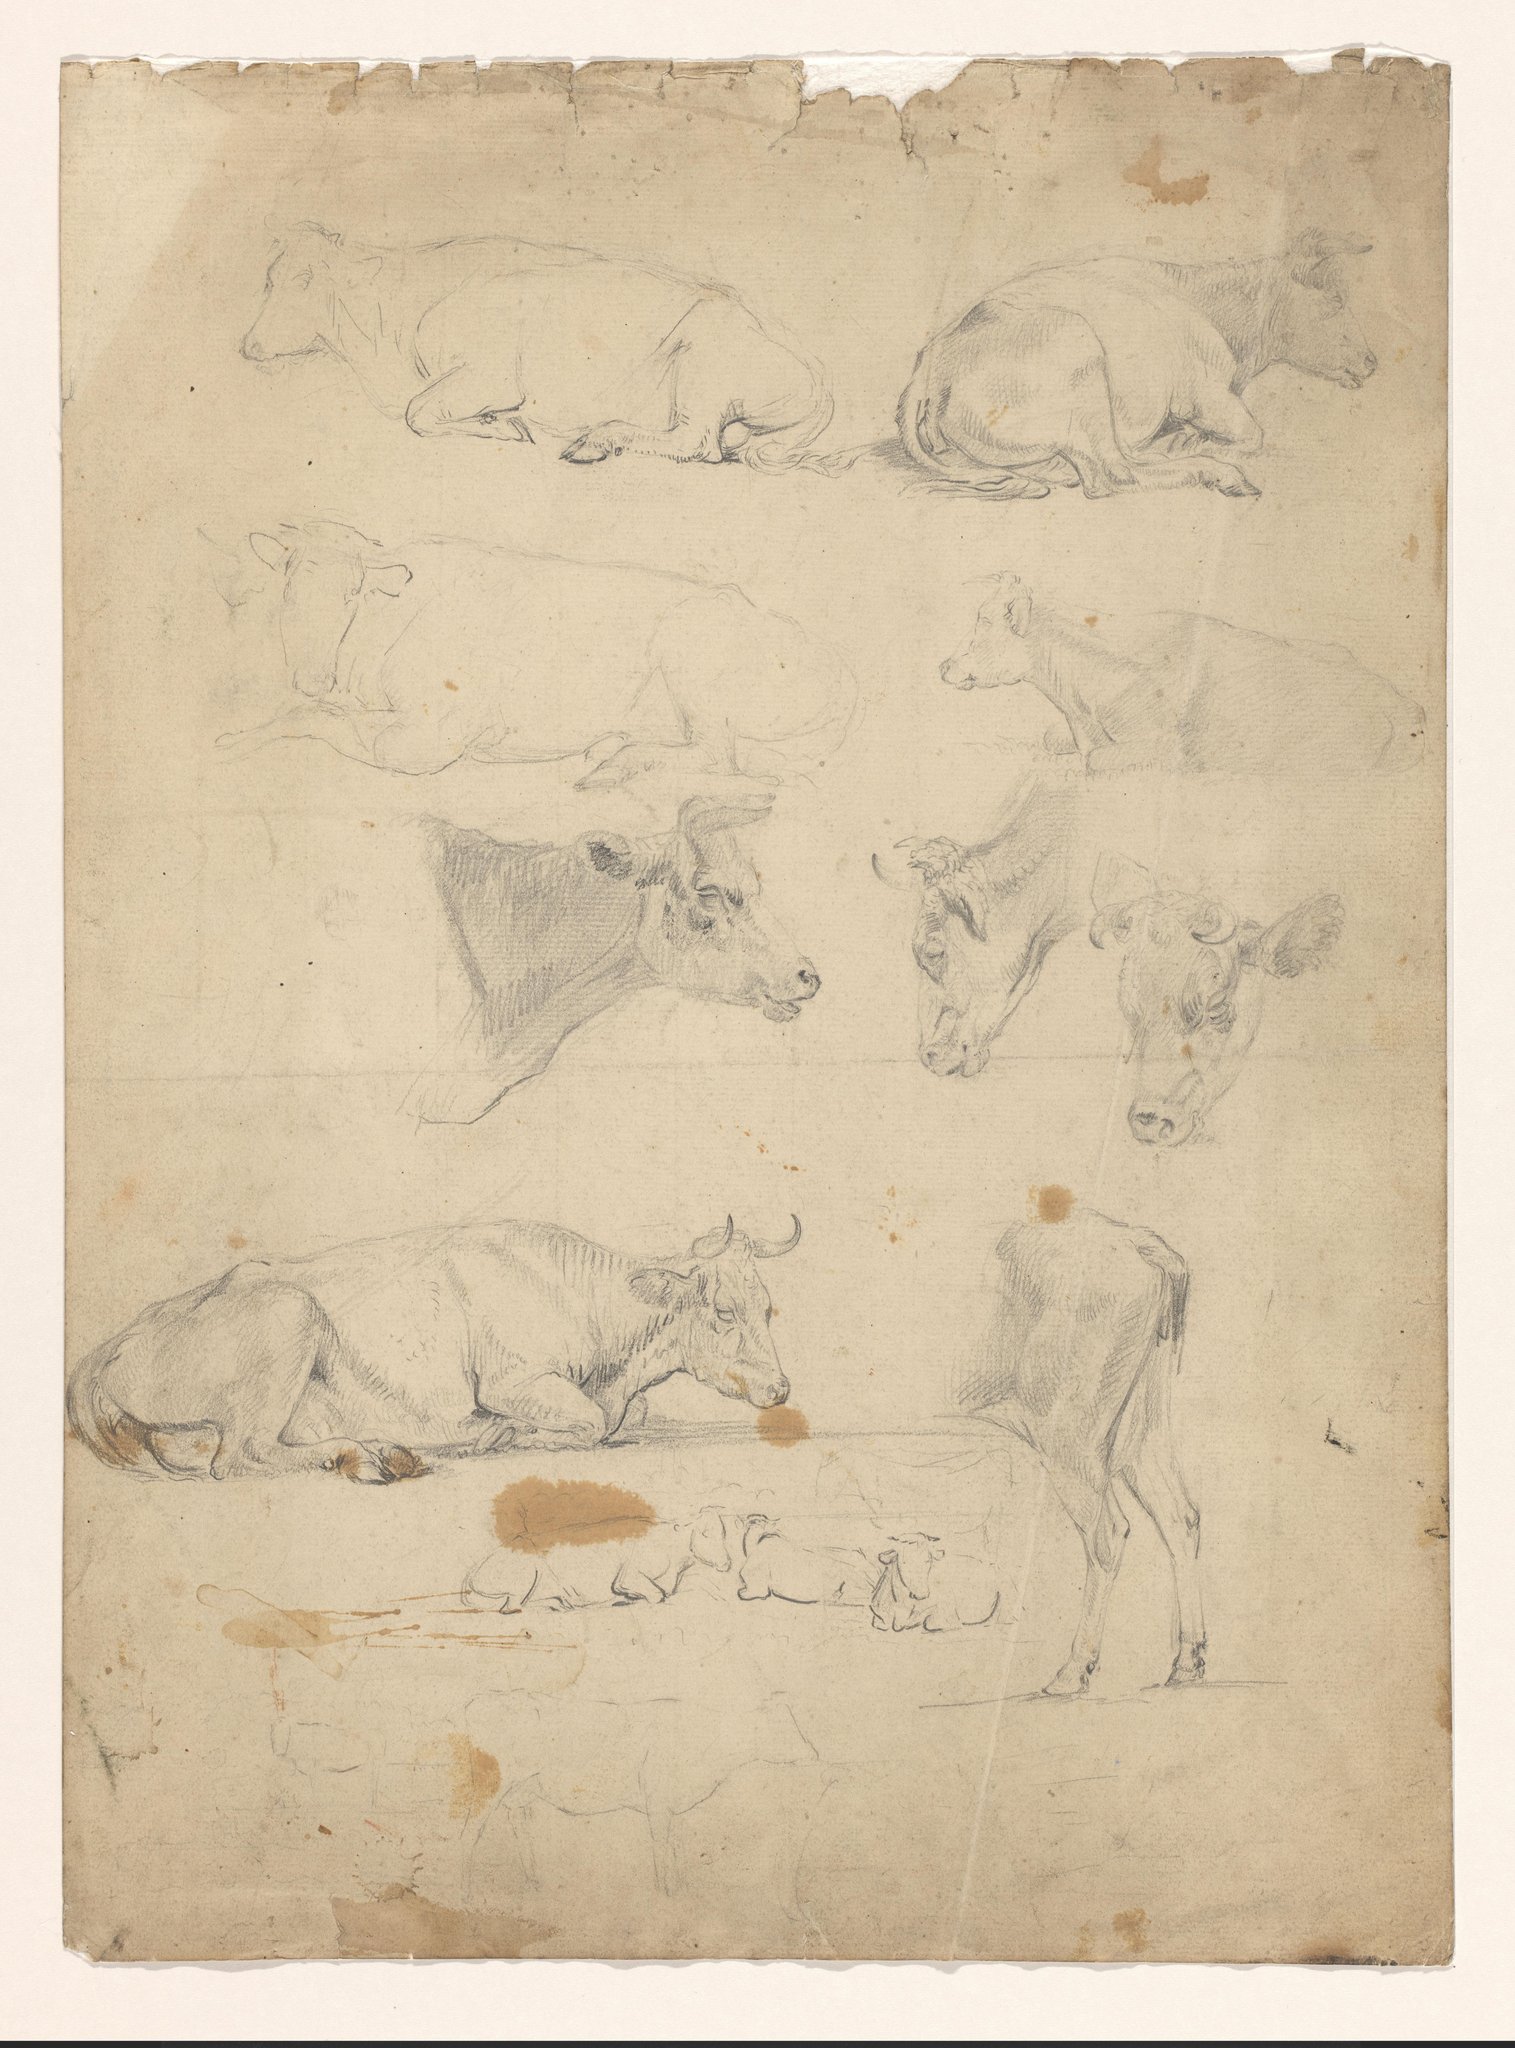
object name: drawing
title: Studieblad met diverse studies van koeien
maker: jan bedijs tom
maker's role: draughtsman, painter, print maker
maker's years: 1813-1894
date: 1823-1894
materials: paper, pencil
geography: the hague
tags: cow